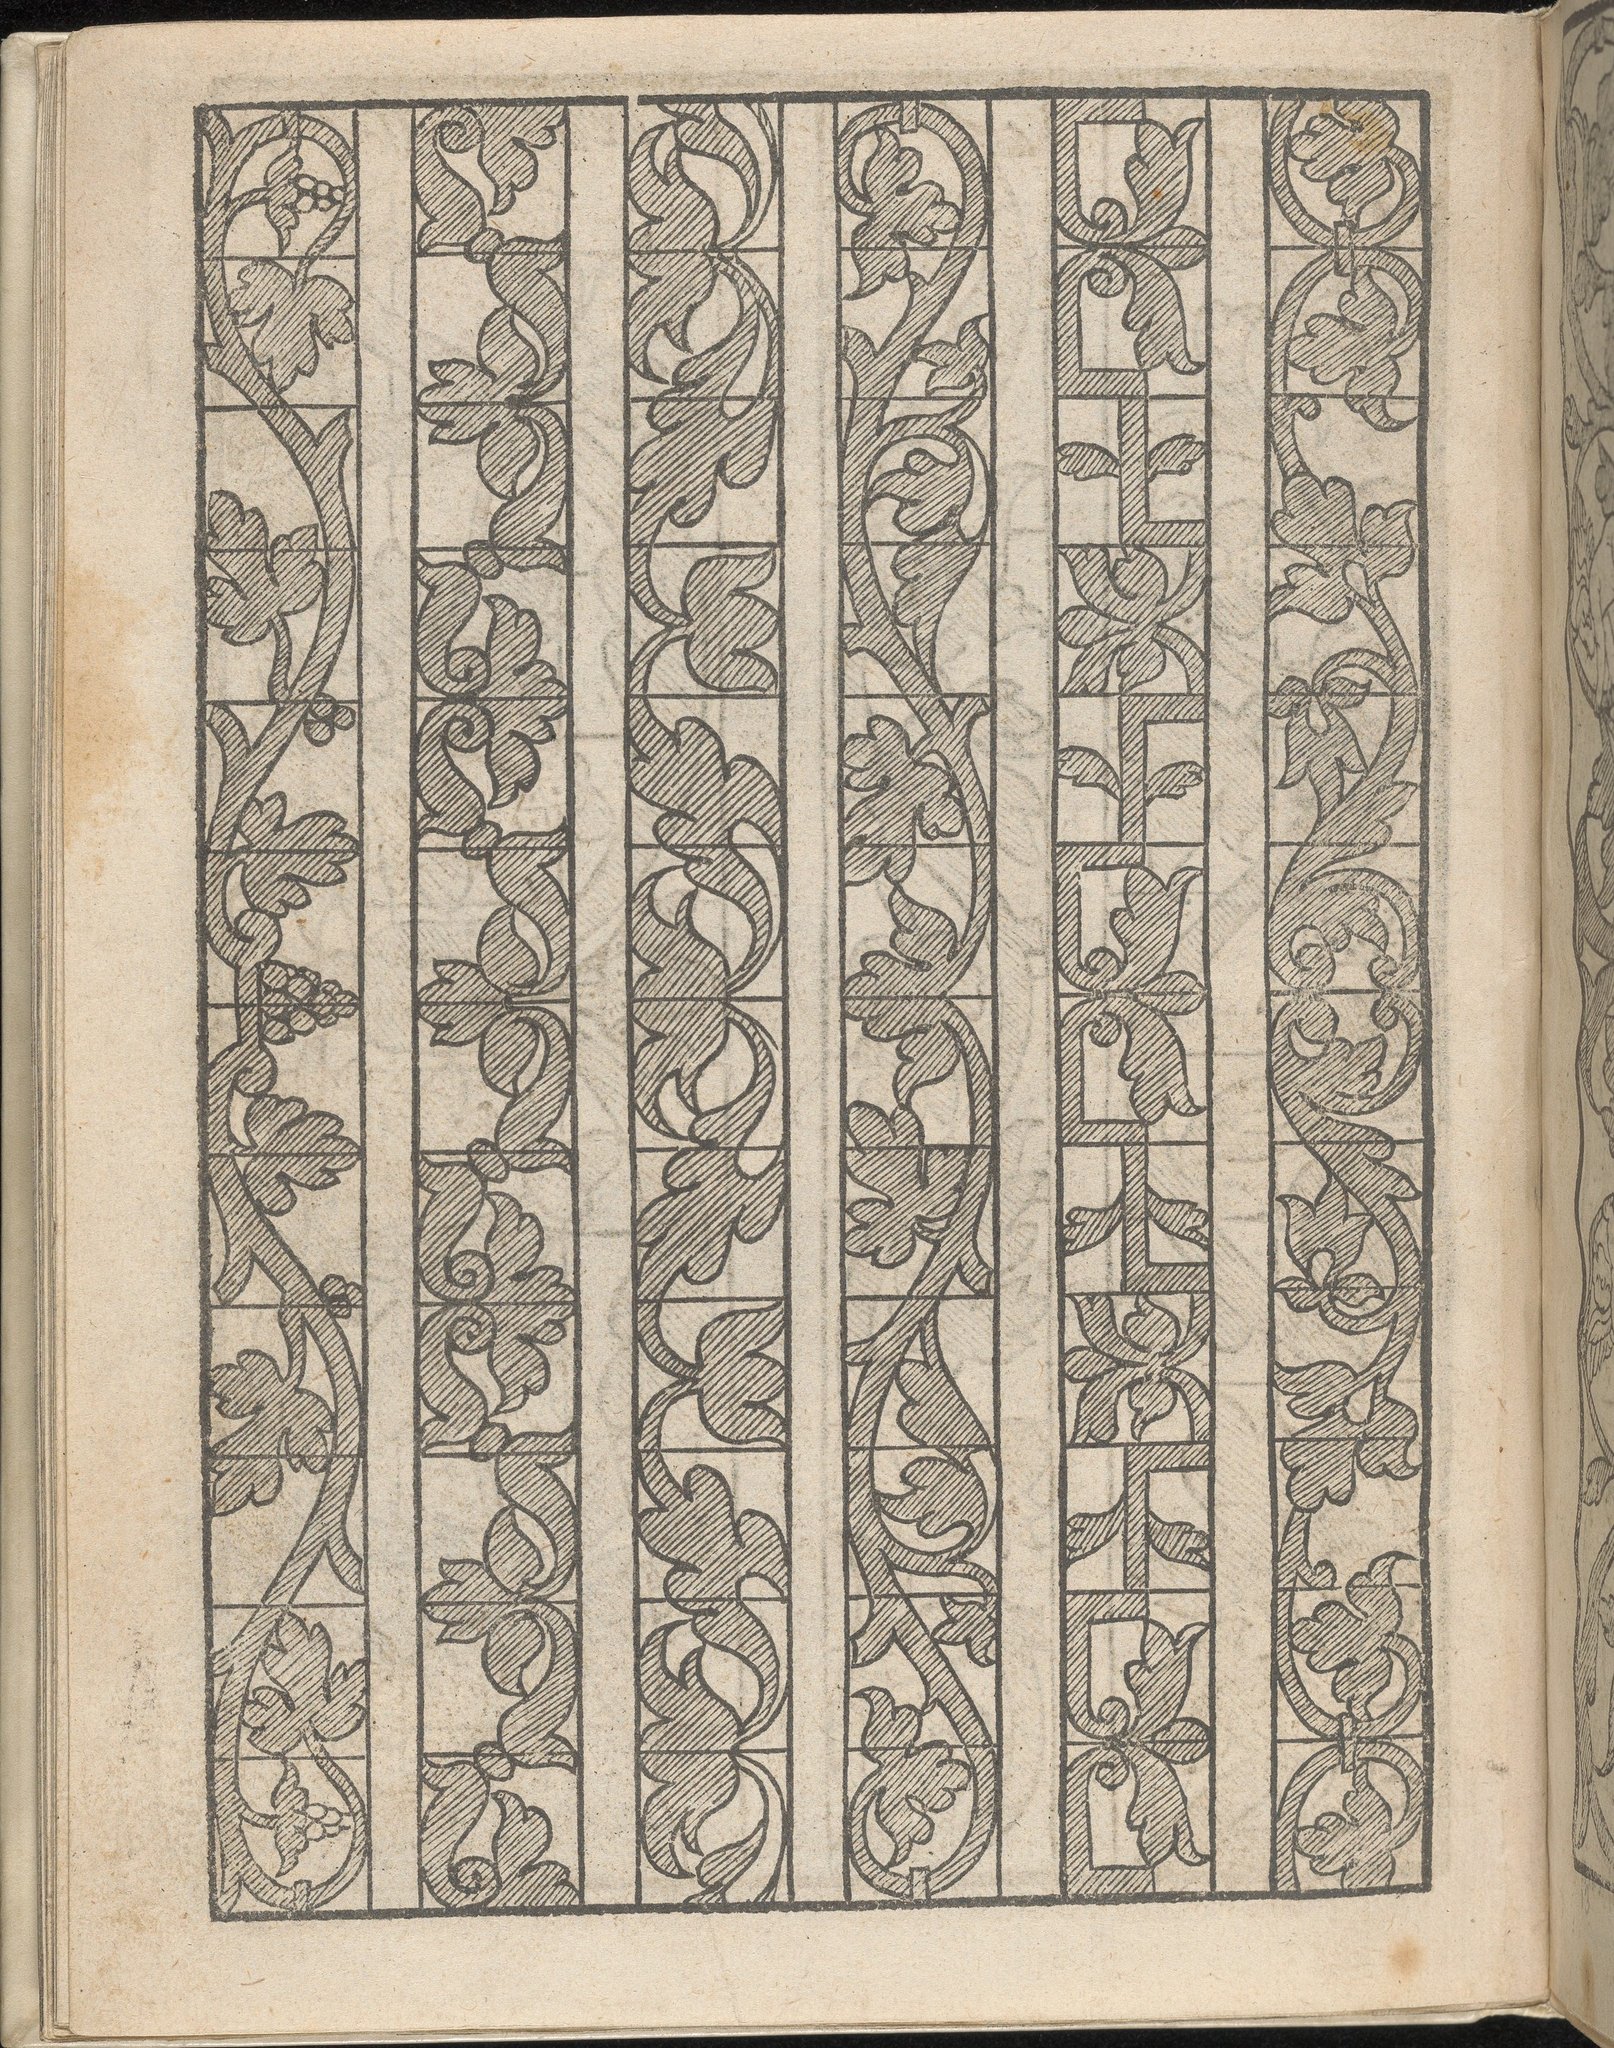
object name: book print ornament architecture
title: Lucidario di Recami, page 15 (recto)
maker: iseppo foresto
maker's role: designer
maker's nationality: italian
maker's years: 1520-1580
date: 1564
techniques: woodcut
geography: italy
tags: flowers